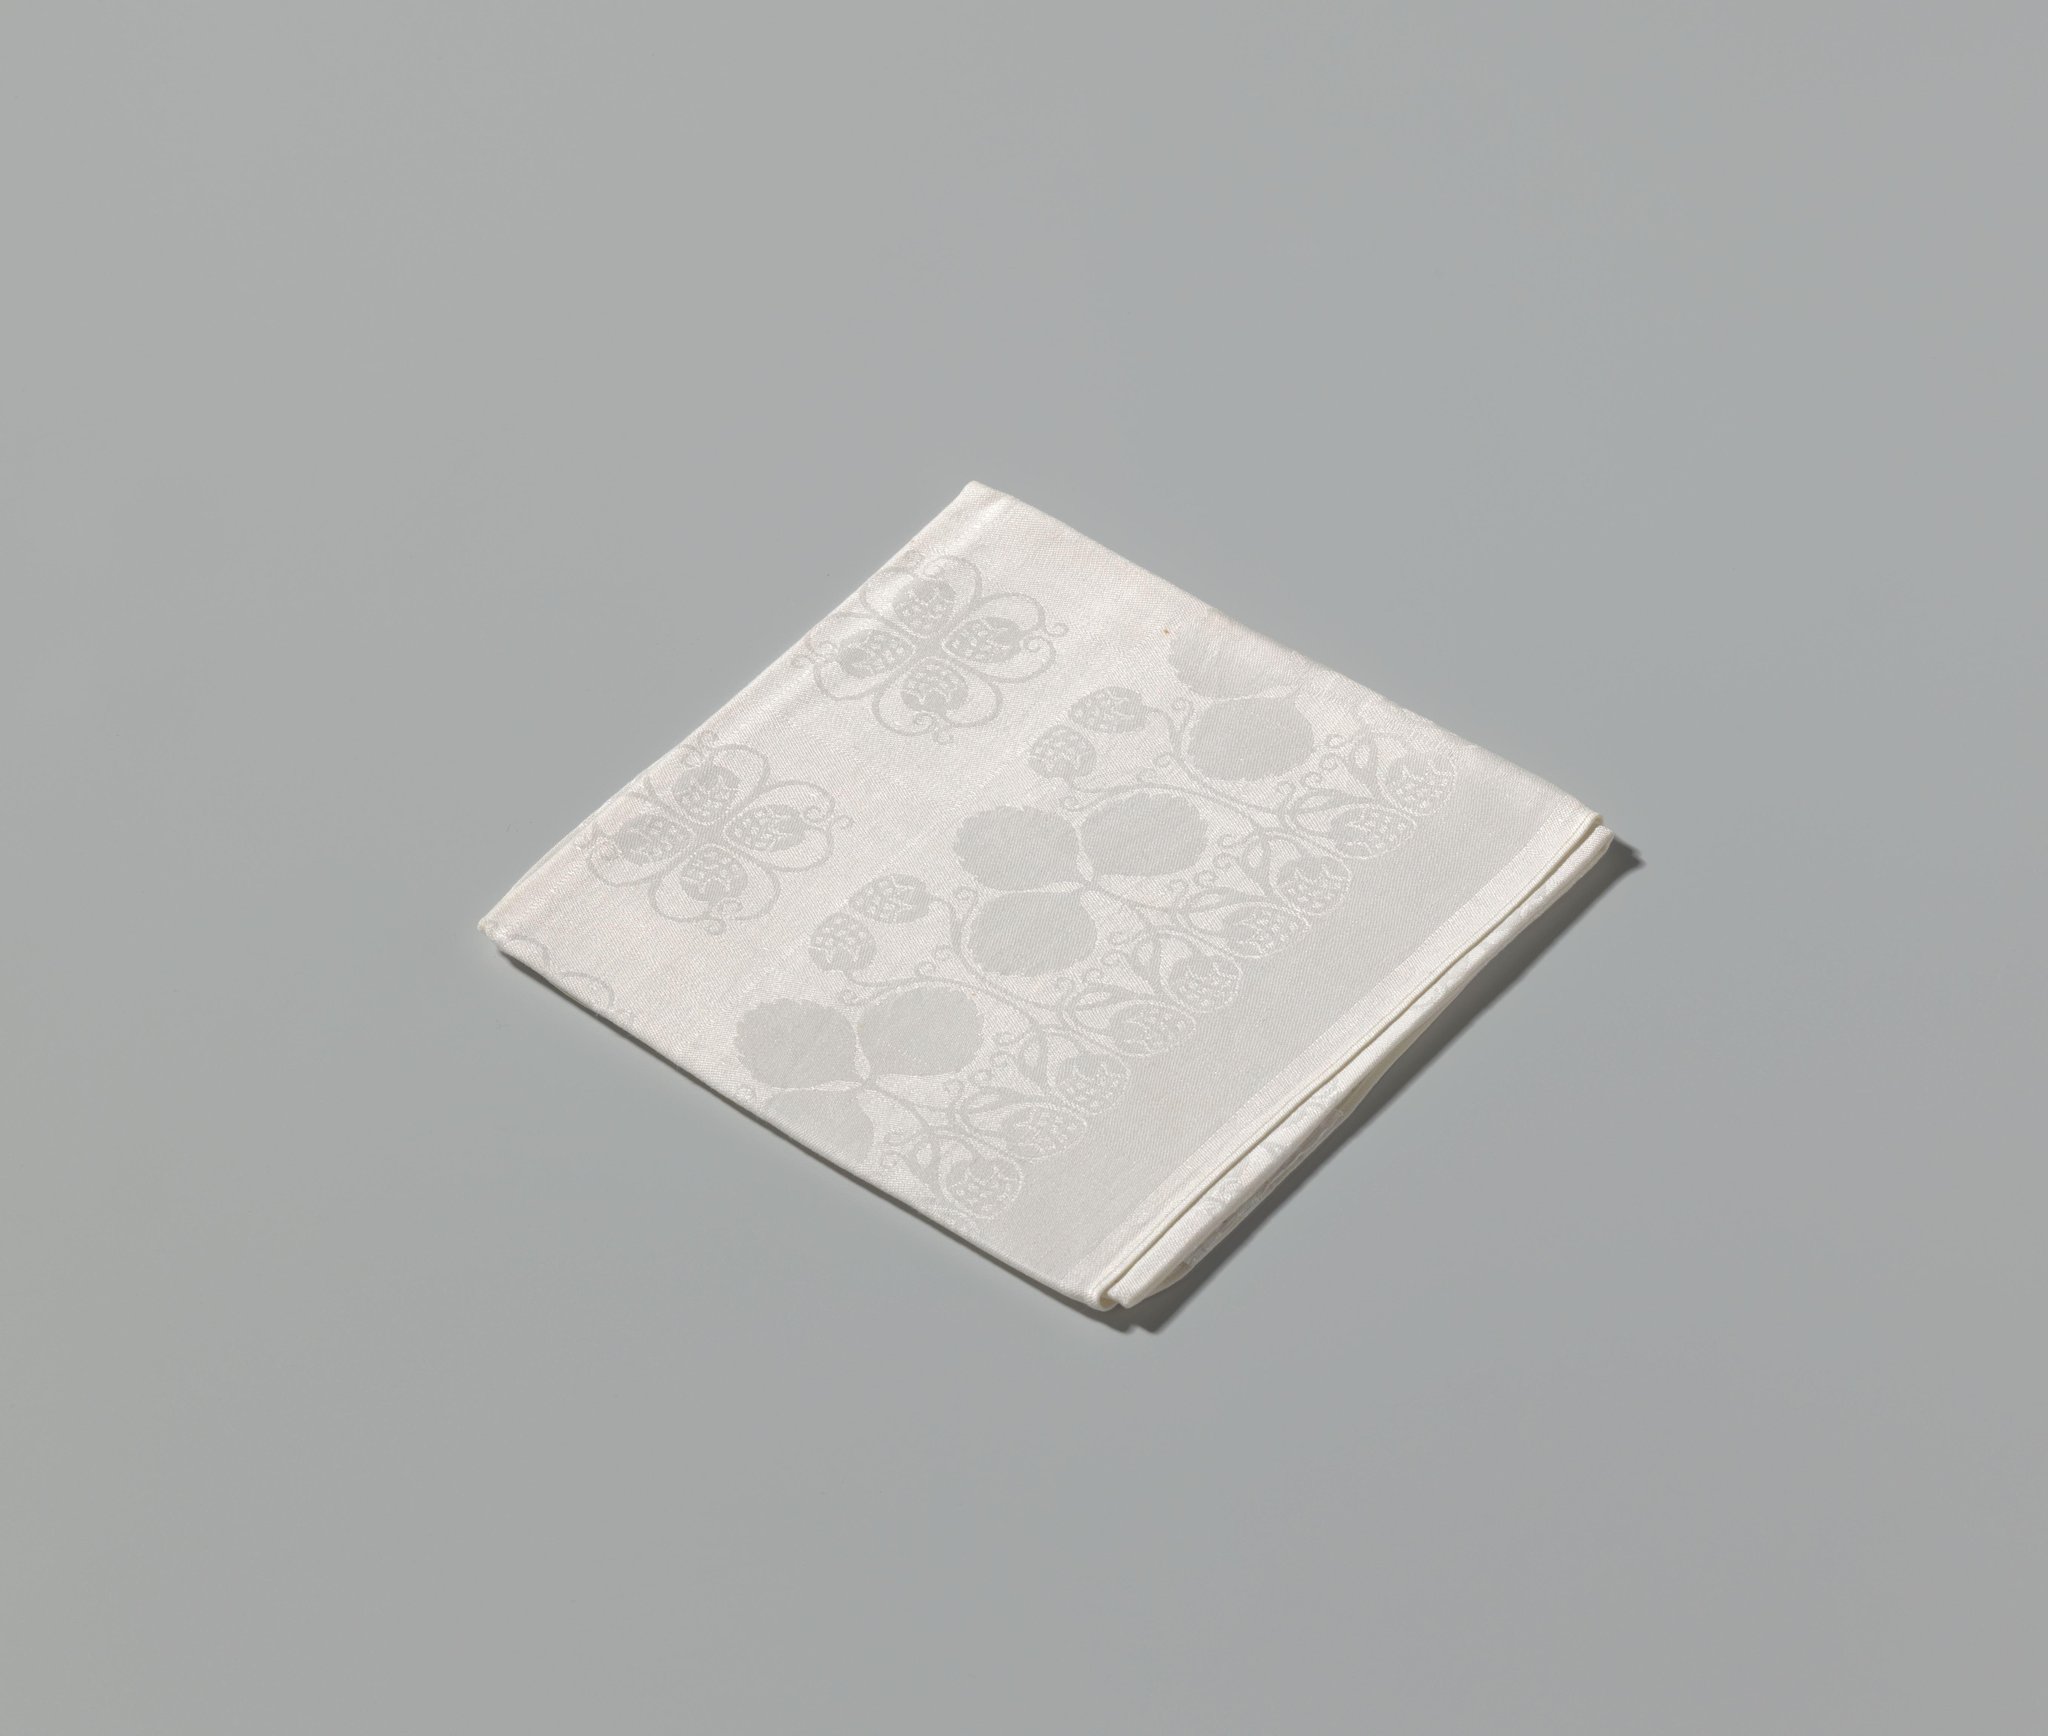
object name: napkin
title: Servet van linnendamast met aardbeien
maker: chris lebeau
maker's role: draughtsman, print maker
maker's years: 1878-1945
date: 1878-1945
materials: linen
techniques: damask, weave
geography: eindhoven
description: Servet van linnendamast met dessin nr. 602: motief aardbei. Het servet hoort bij vijf servetten (BK-1979-264-A t/m BK-1979-264-F) en een tafellaken (BK-1979-263).